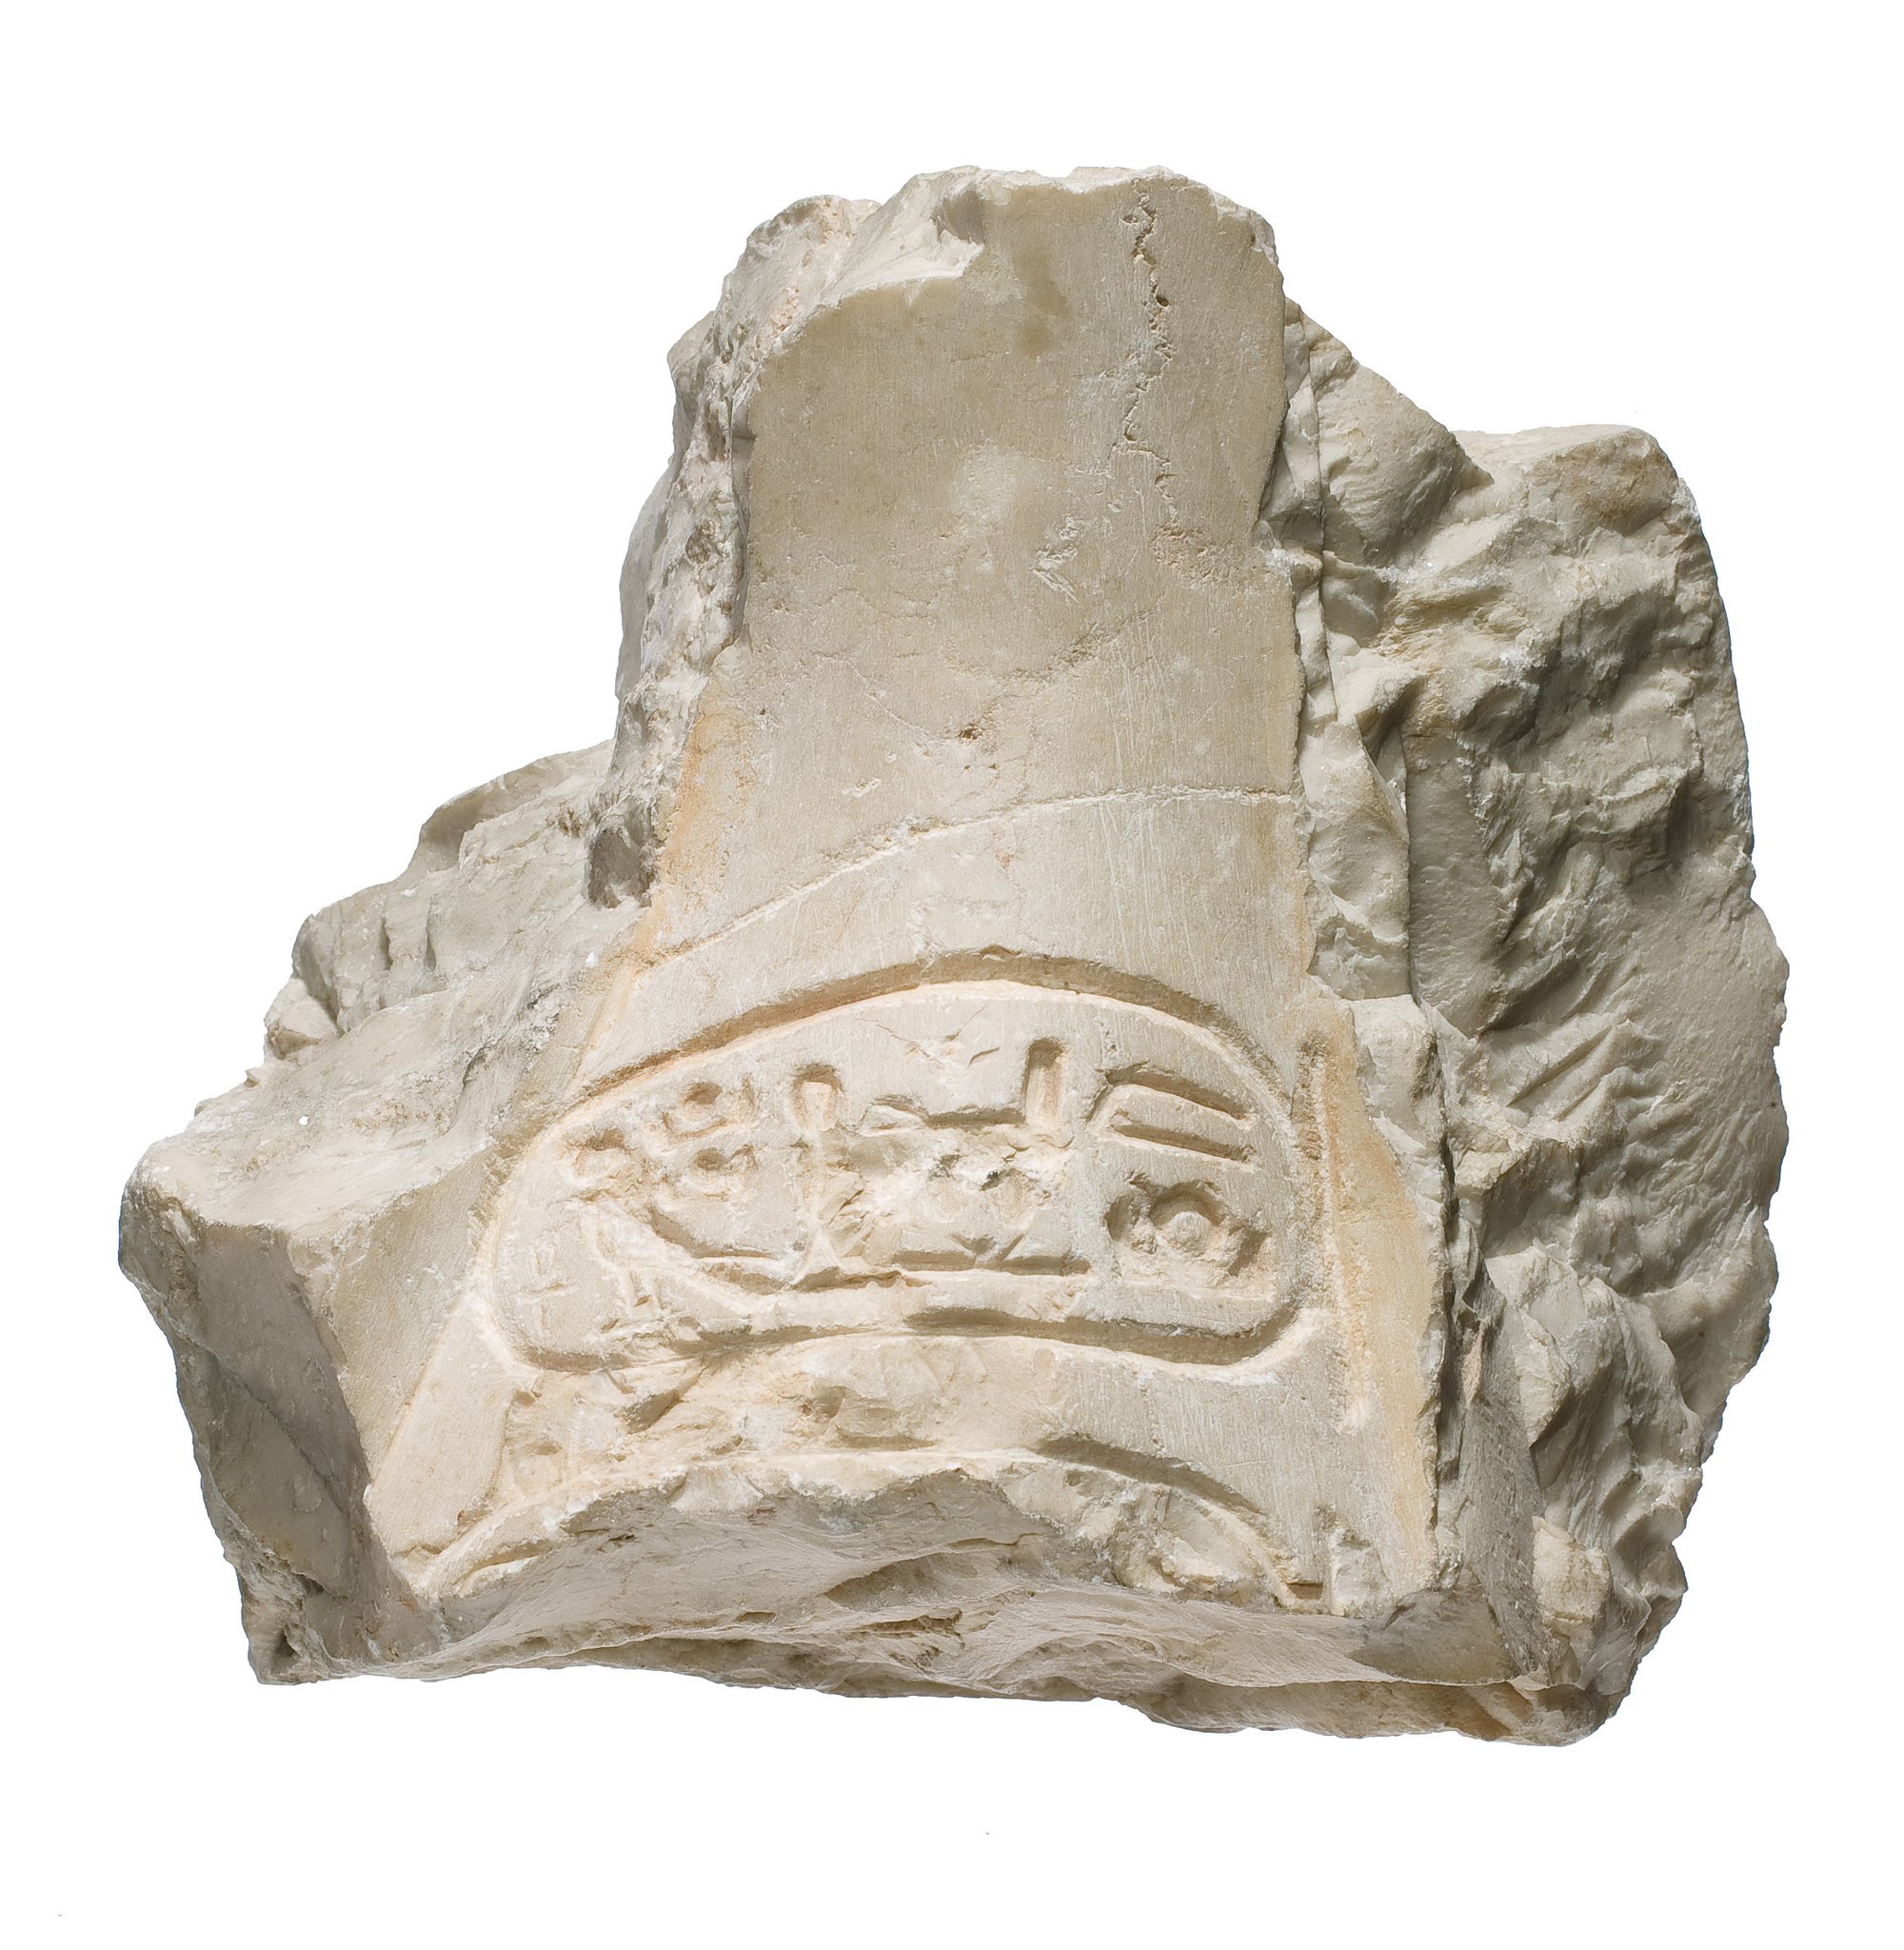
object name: torso belt fragment of akhenaten, with cartouche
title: Torso/Belt of the king with cartouches of the Aten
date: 1353-1336 BCE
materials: limestone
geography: egypt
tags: hieroglyphs